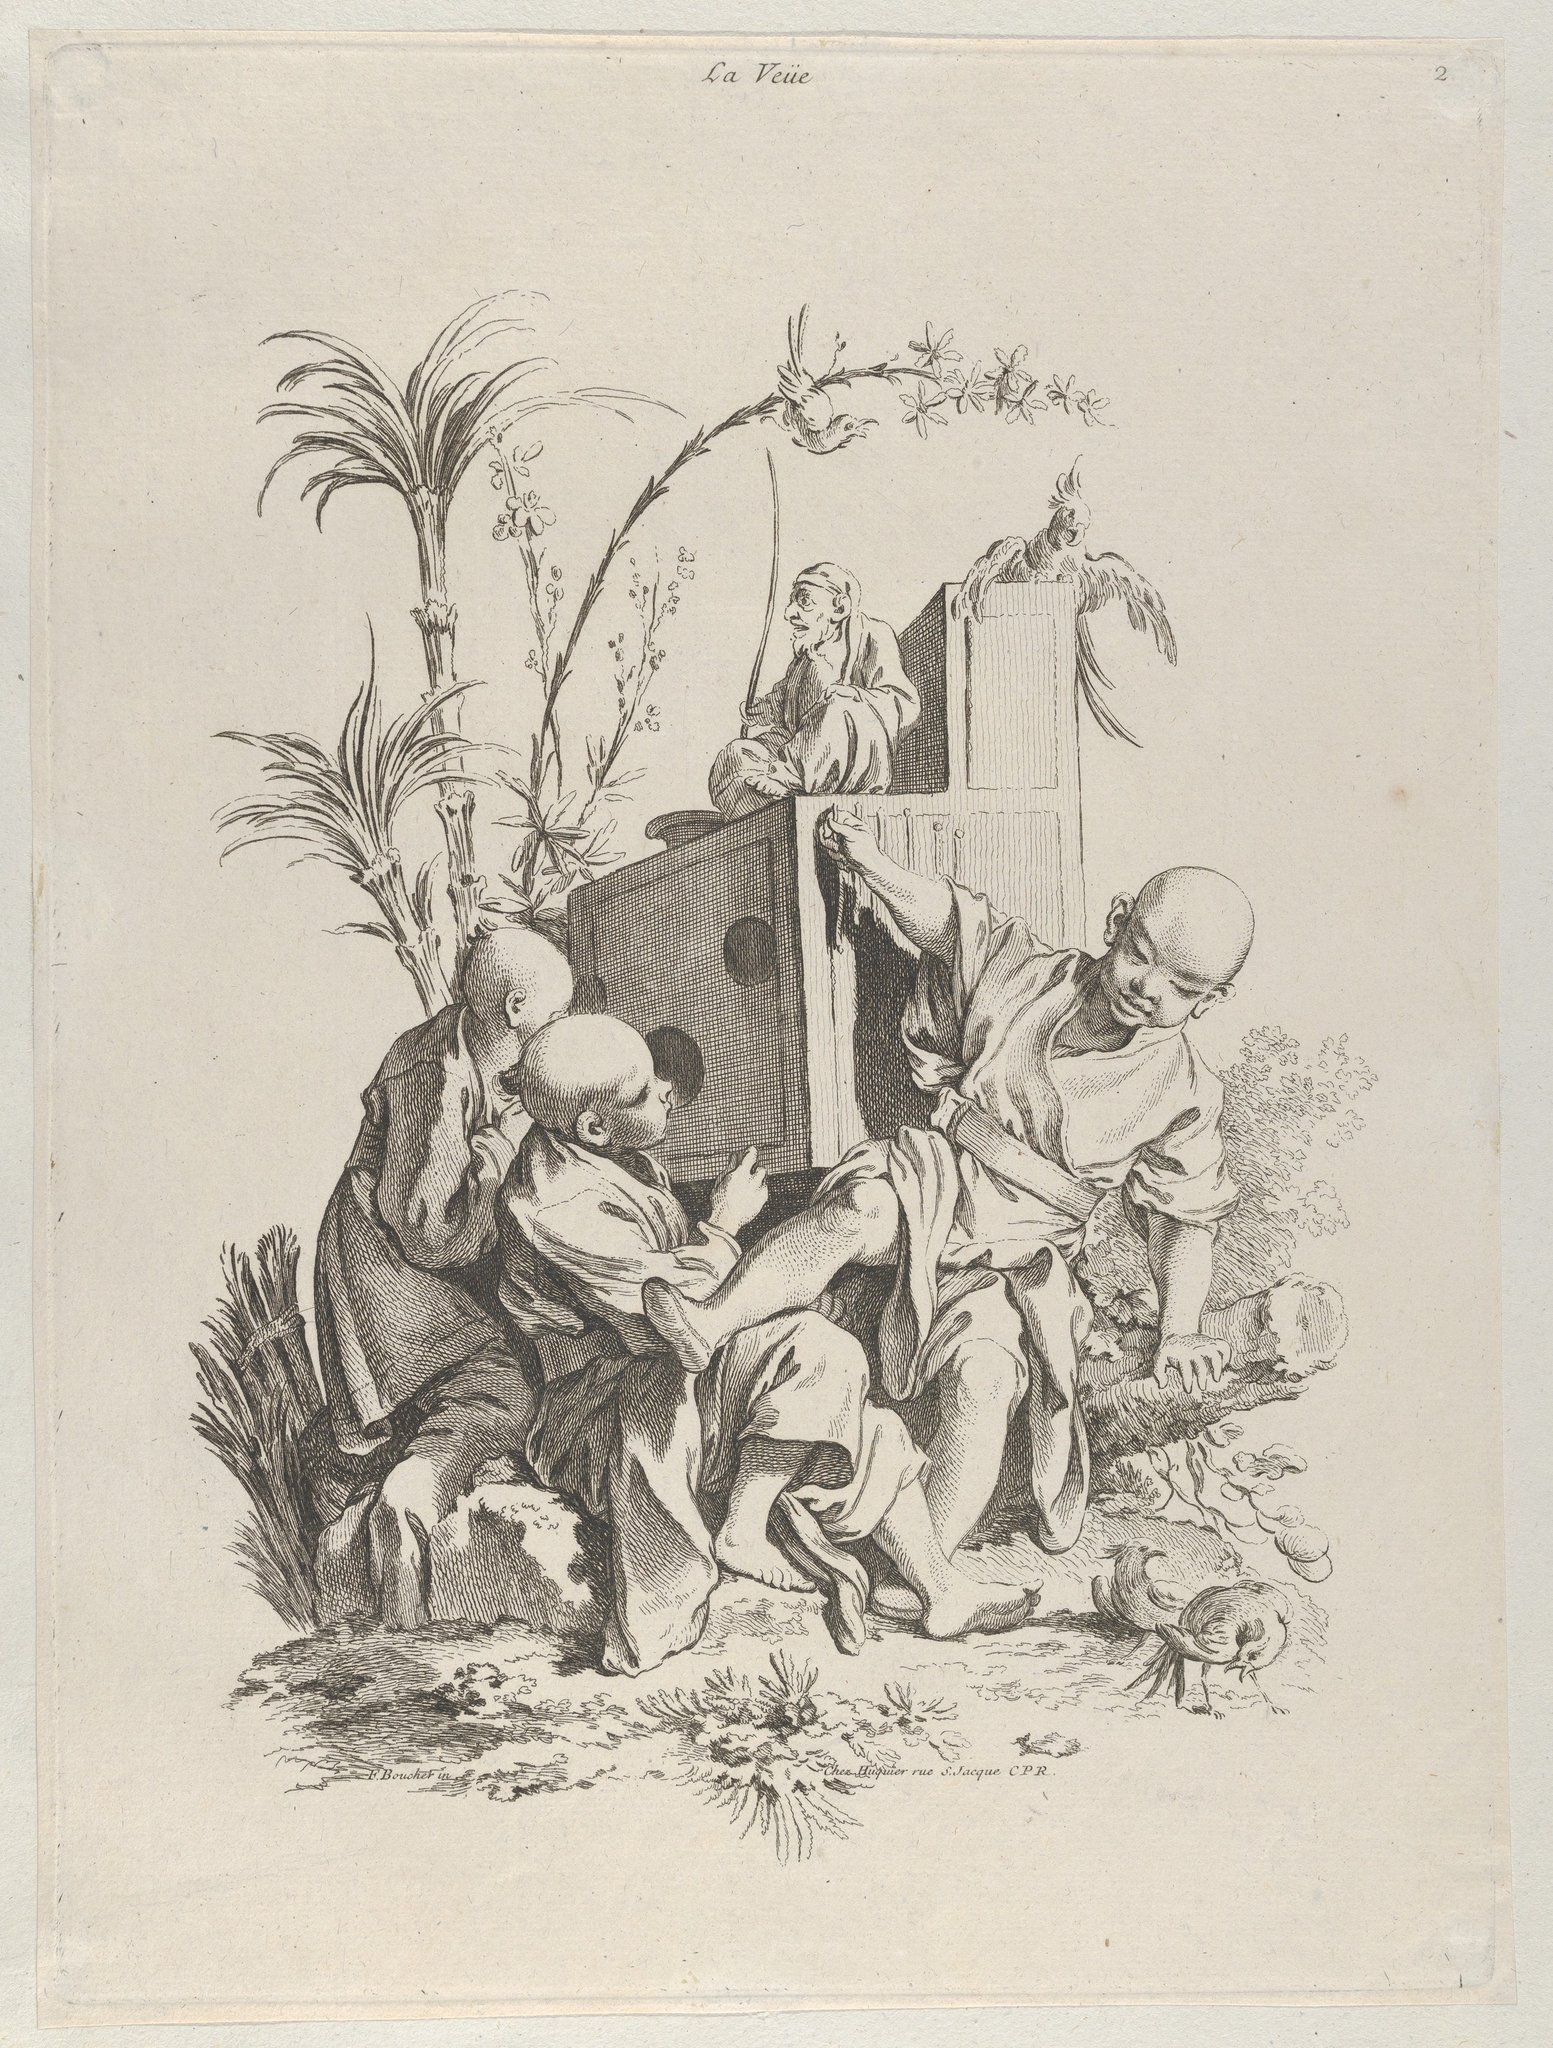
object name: print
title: Sight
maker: françois boucher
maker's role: artist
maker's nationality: french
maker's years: 1703-1770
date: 1720-1770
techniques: engraving, etching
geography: france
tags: boys,men,plants